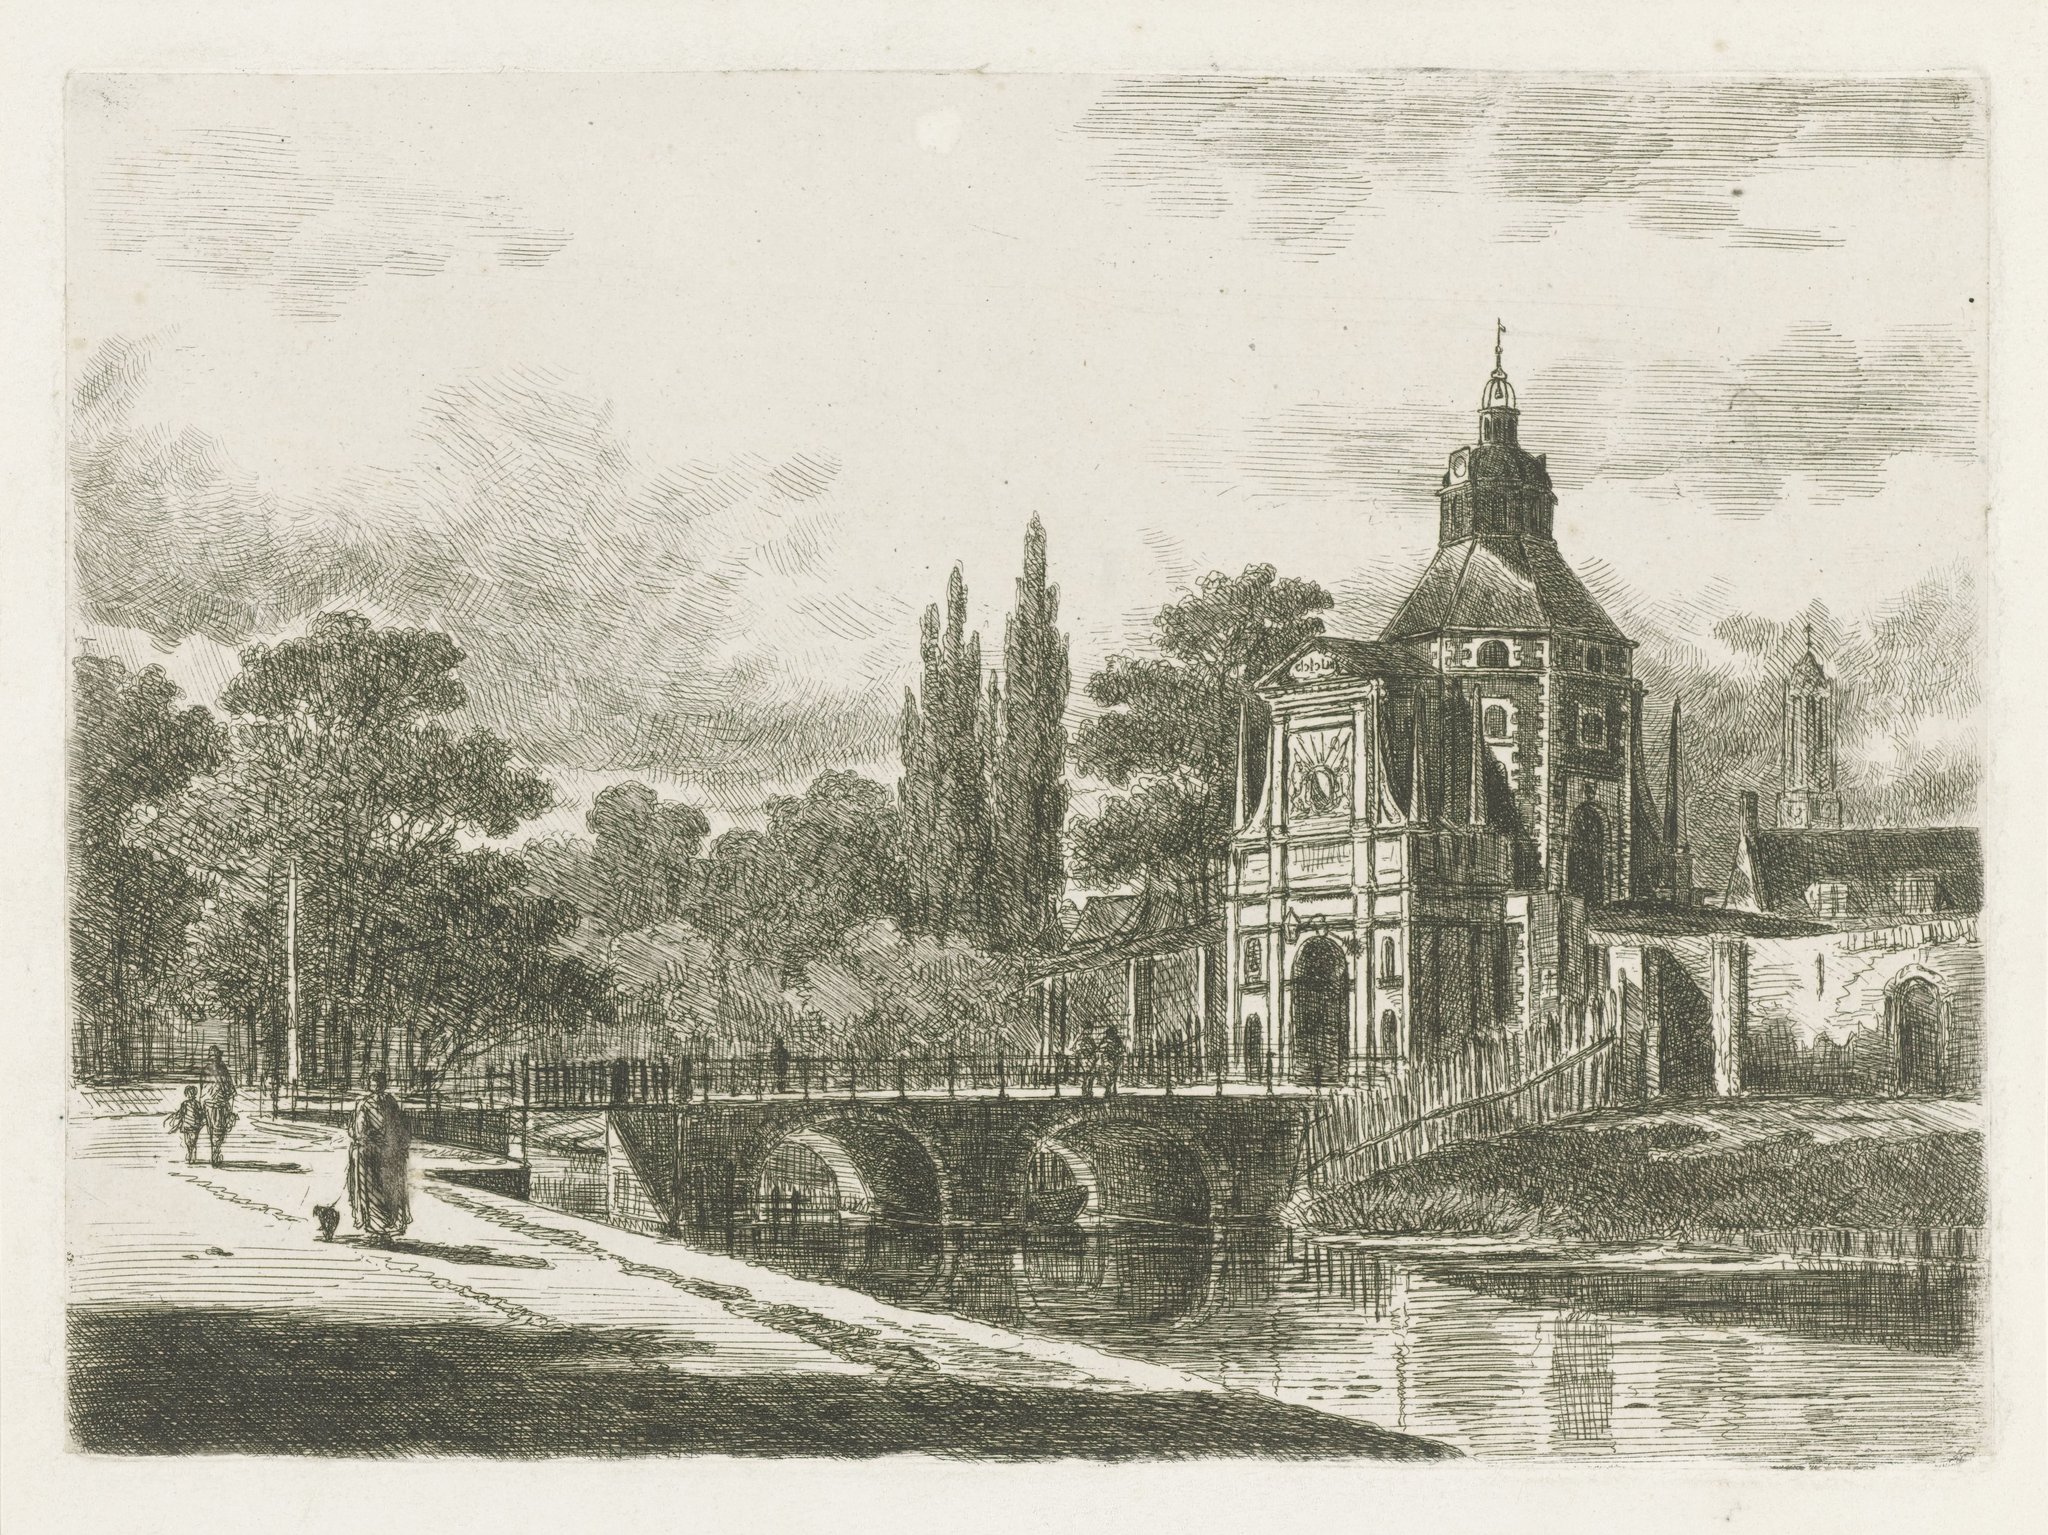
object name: print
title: Wittevrouwenpoort te Utrecht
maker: jan van lokhorst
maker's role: draughtsman, print maker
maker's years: 1837-1894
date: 1847-1874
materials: paper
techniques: etching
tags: city-walls, city-gate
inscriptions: collector's mark: Lugt 2228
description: Gezicht op de Wittevrouwenpoort te Utrecht, gezien van buiten de stadsmuur. Links lopen enkele figuren op een weg langs de Wittevrouwensingel.